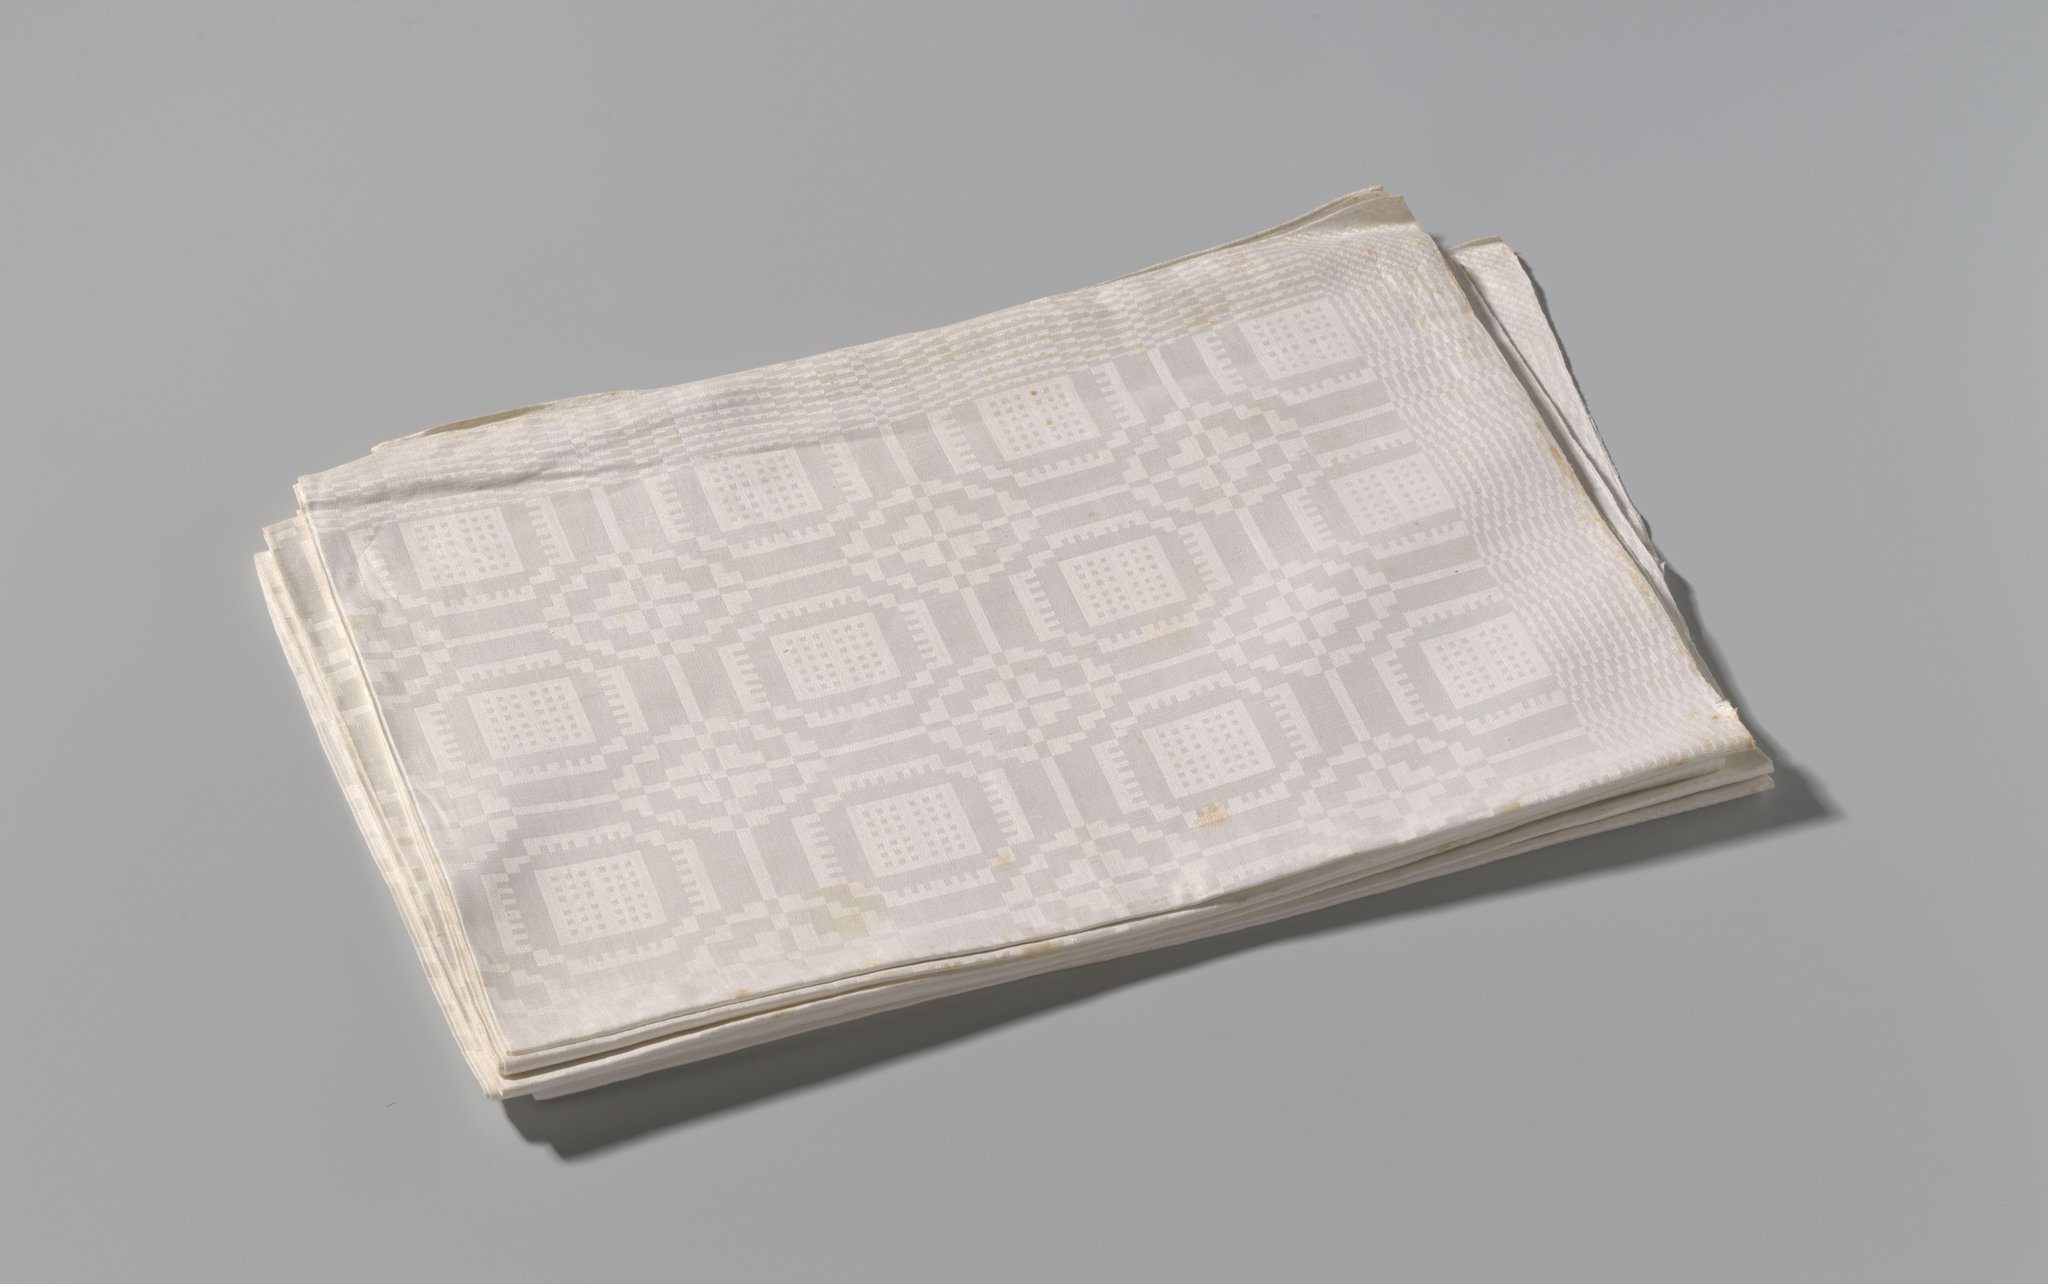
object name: tablecloth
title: Tafellaken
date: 1700-1799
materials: linen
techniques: peeled fabric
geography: netherlands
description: Wit linnen tafellaken met een pellen patroon en randen rondom, merk BS 3 WH 2oonl.